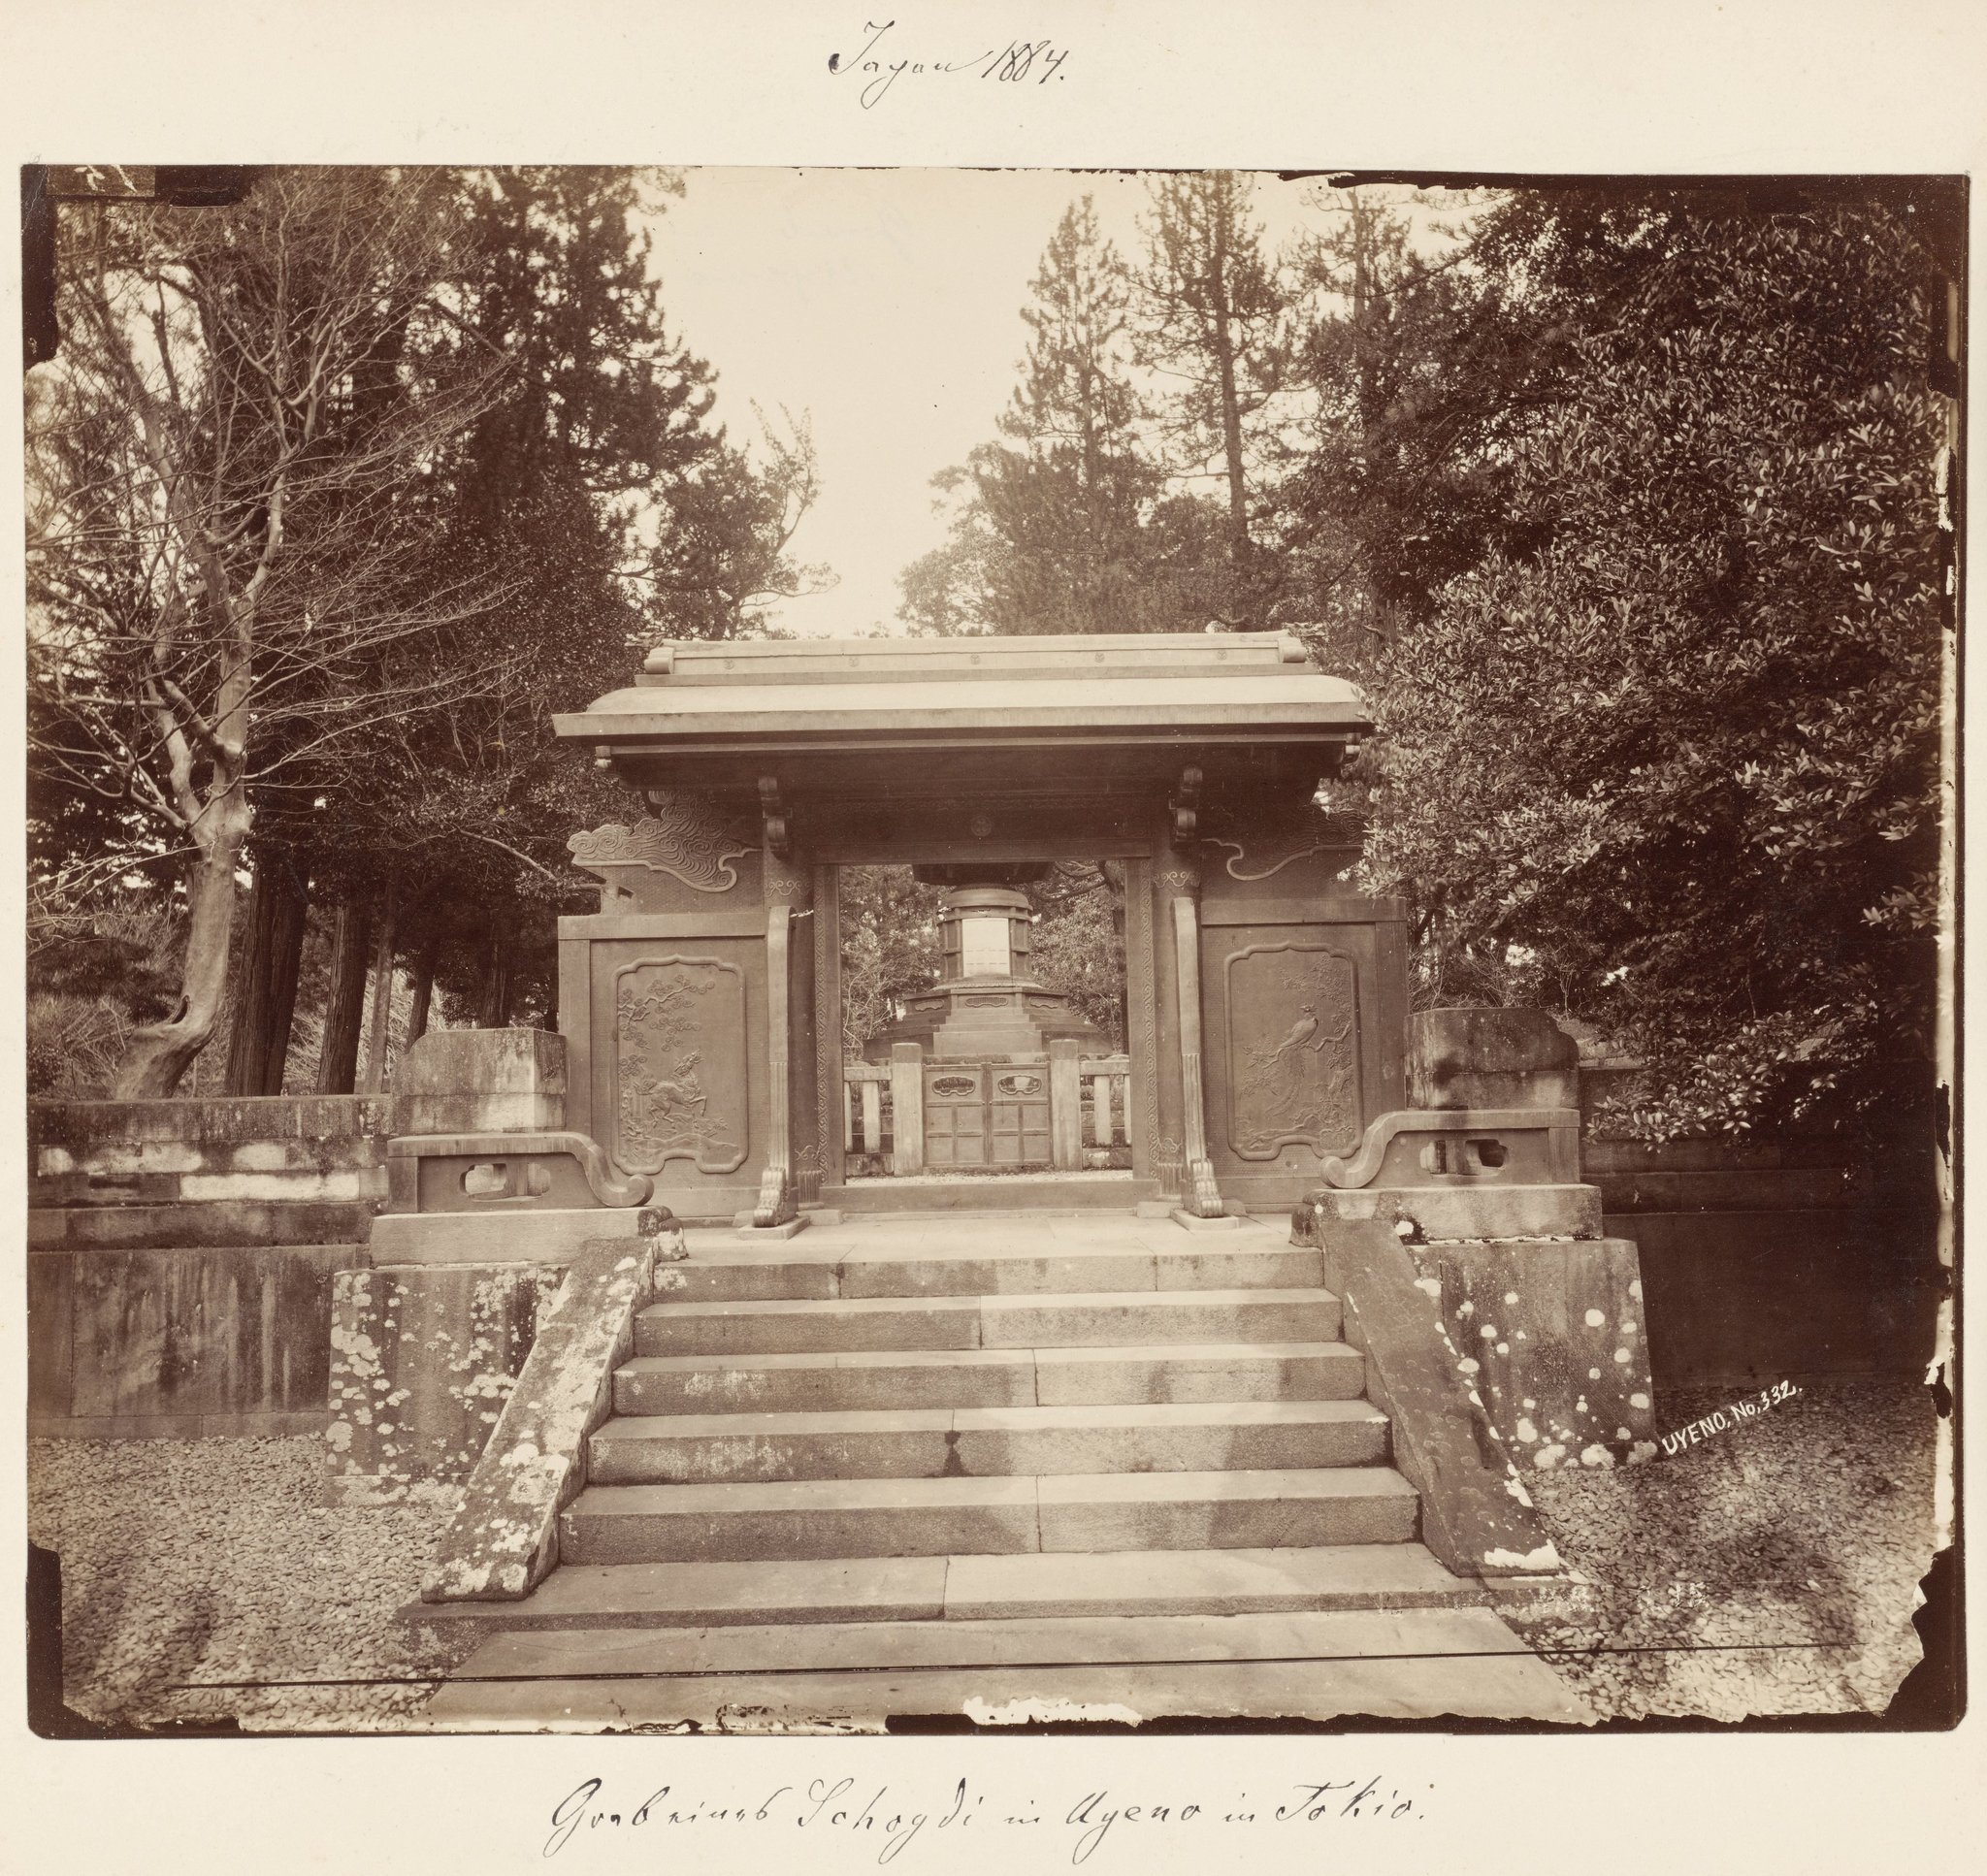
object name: photograph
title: Japan 1884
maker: Anonymous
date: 1884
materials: cardboard, paper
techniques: albumen print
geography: shibapark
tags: mausoleum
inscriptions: number: ‘No, 332.’, inscription: ‘Grab [...] Schogdi in Uyeno in Tokio [?]’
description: Titel op object geeft onjuiste informatie. Het afgebeelde mausoleum is van shogun Tokugawa Ienobu in Zōjō-ji in Shibapark. In Uenopark (ook in Tokyo) staan mausoleums van twee andere Tokugawa shoguns: Tokugawa Yoshimune en Tokugawa Yoshinobu. Tokugawa Ienobu (1661-1712) was de zesde shogun van de Tokugawa dynastie. Zijn graftombe in Zōjō-ji werd in 1712 gebouwd en in 1945 vernietigd tijdens een bombardement op Tokyo.